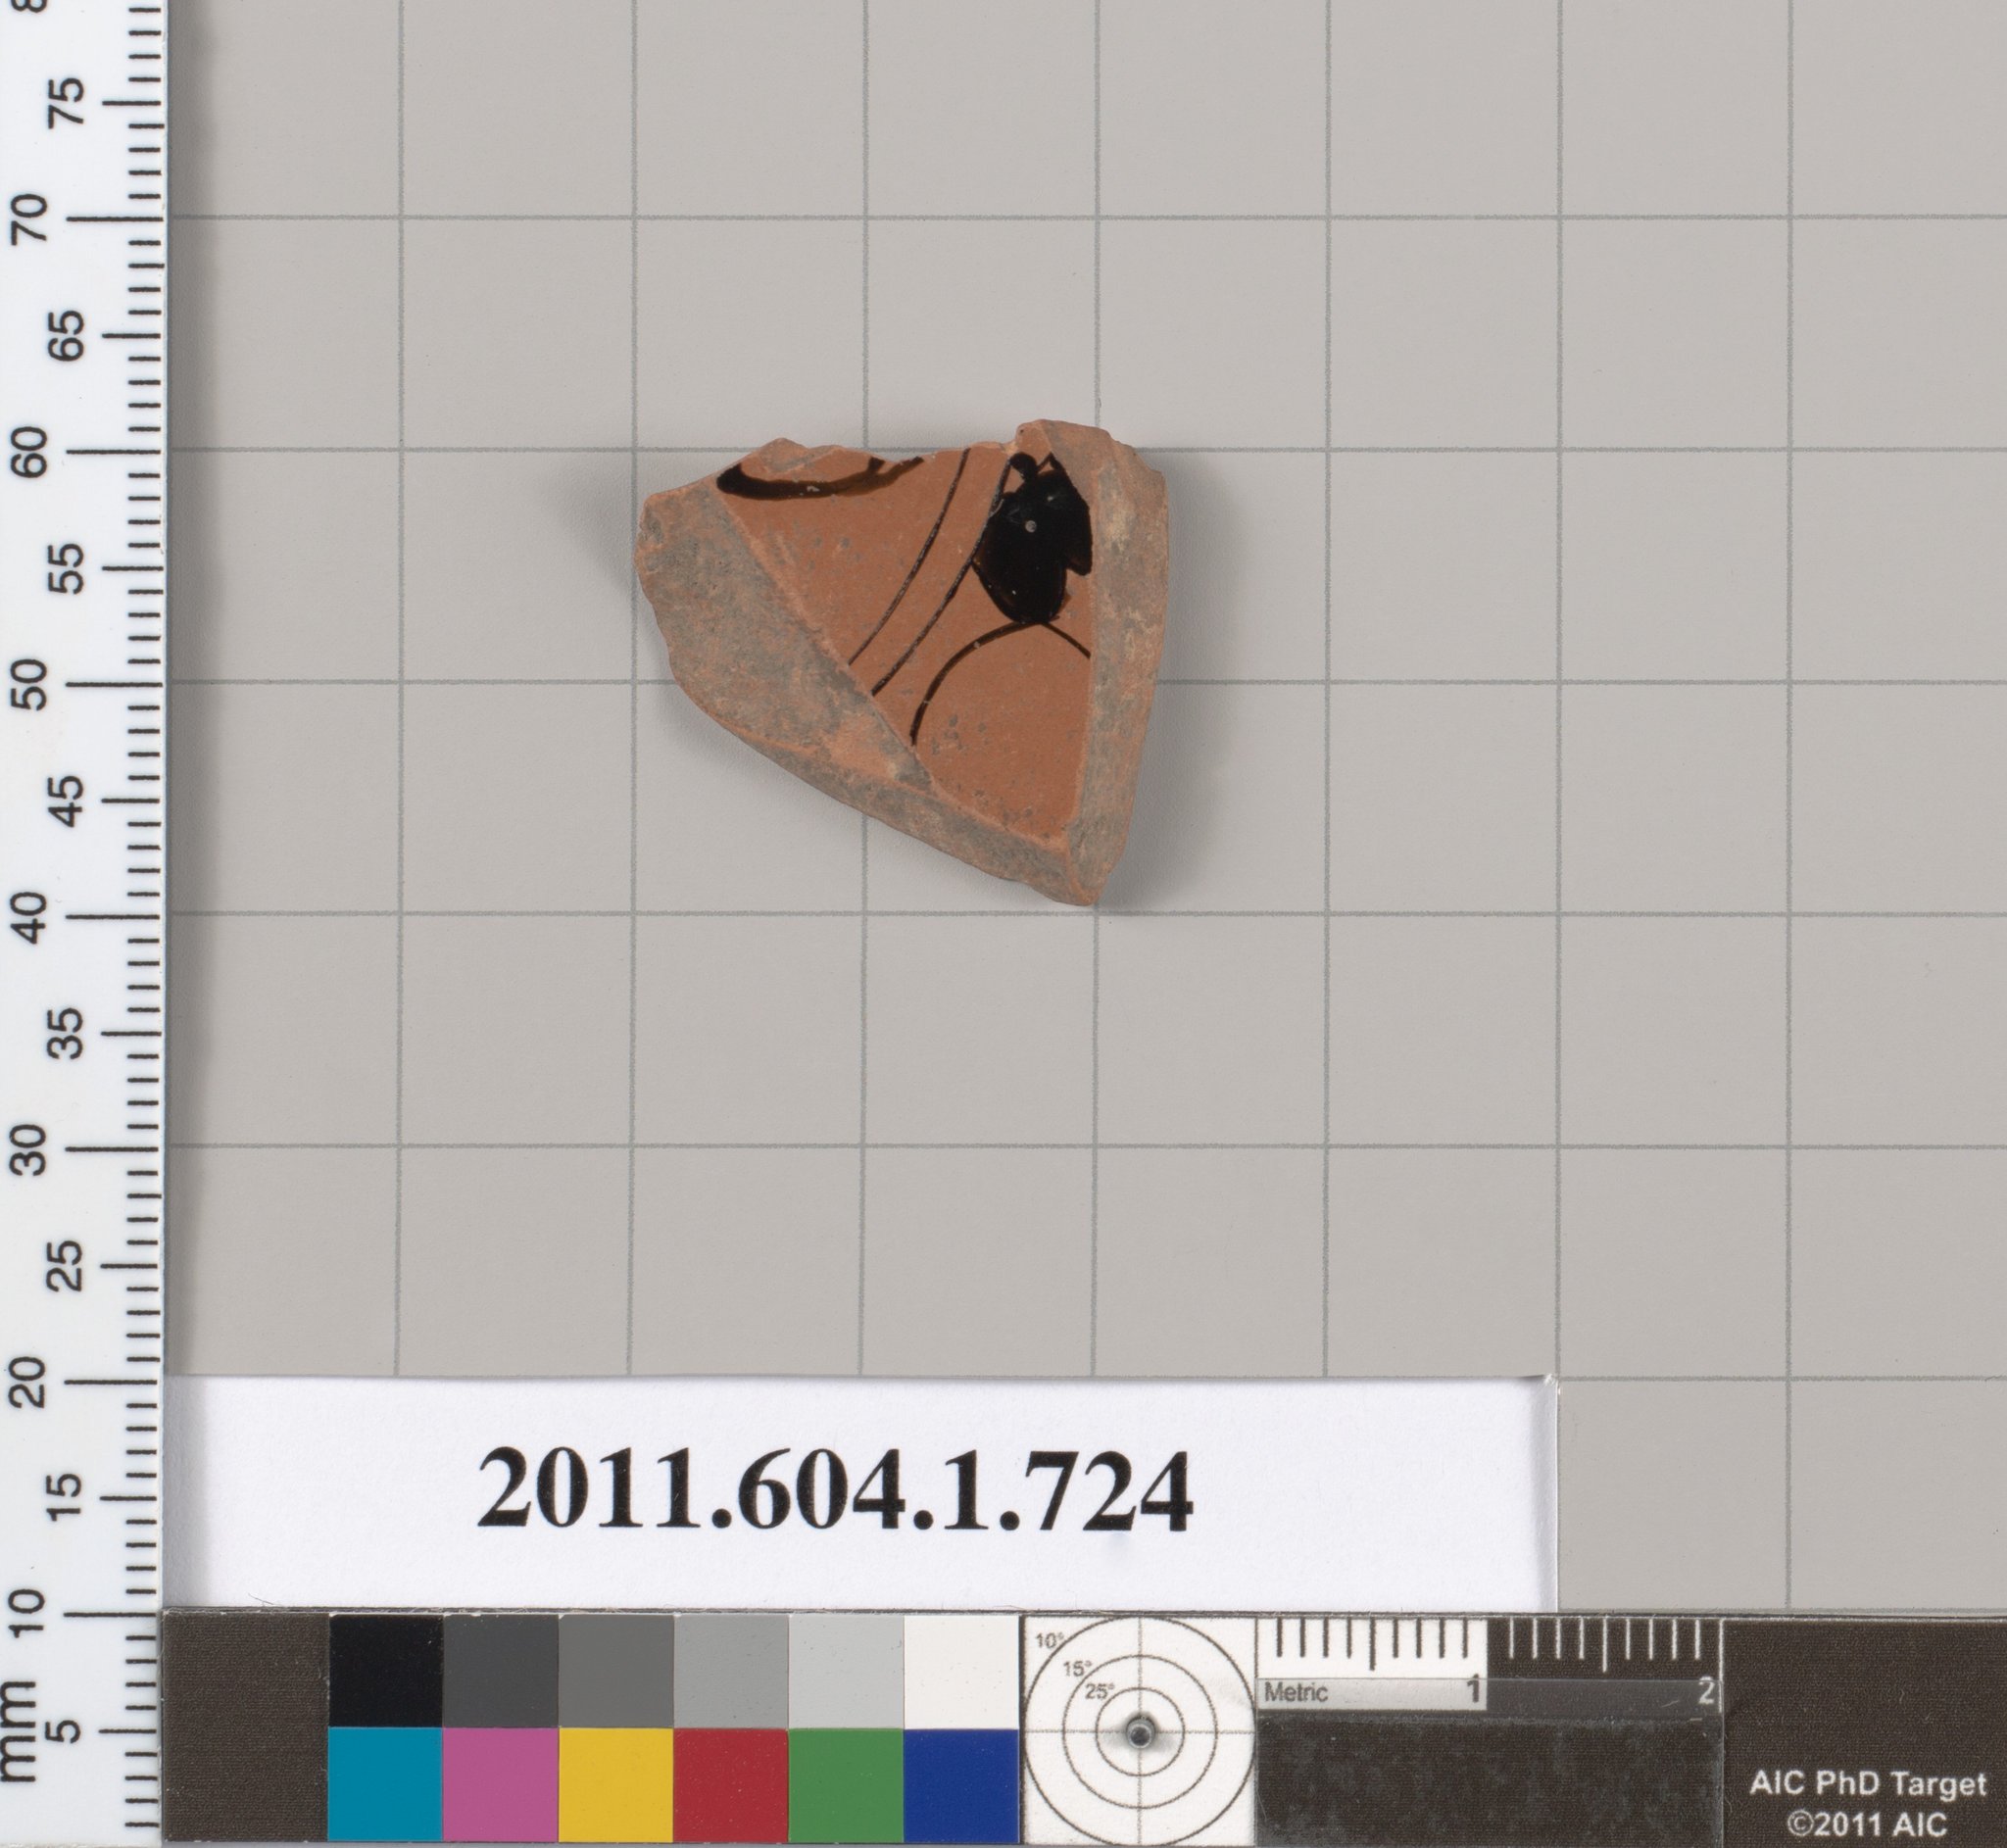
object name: kylix fragment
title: Terracotta fragment of a kylix (drinking cup)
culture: greek, attic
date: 475-451 BCE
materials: terracotta